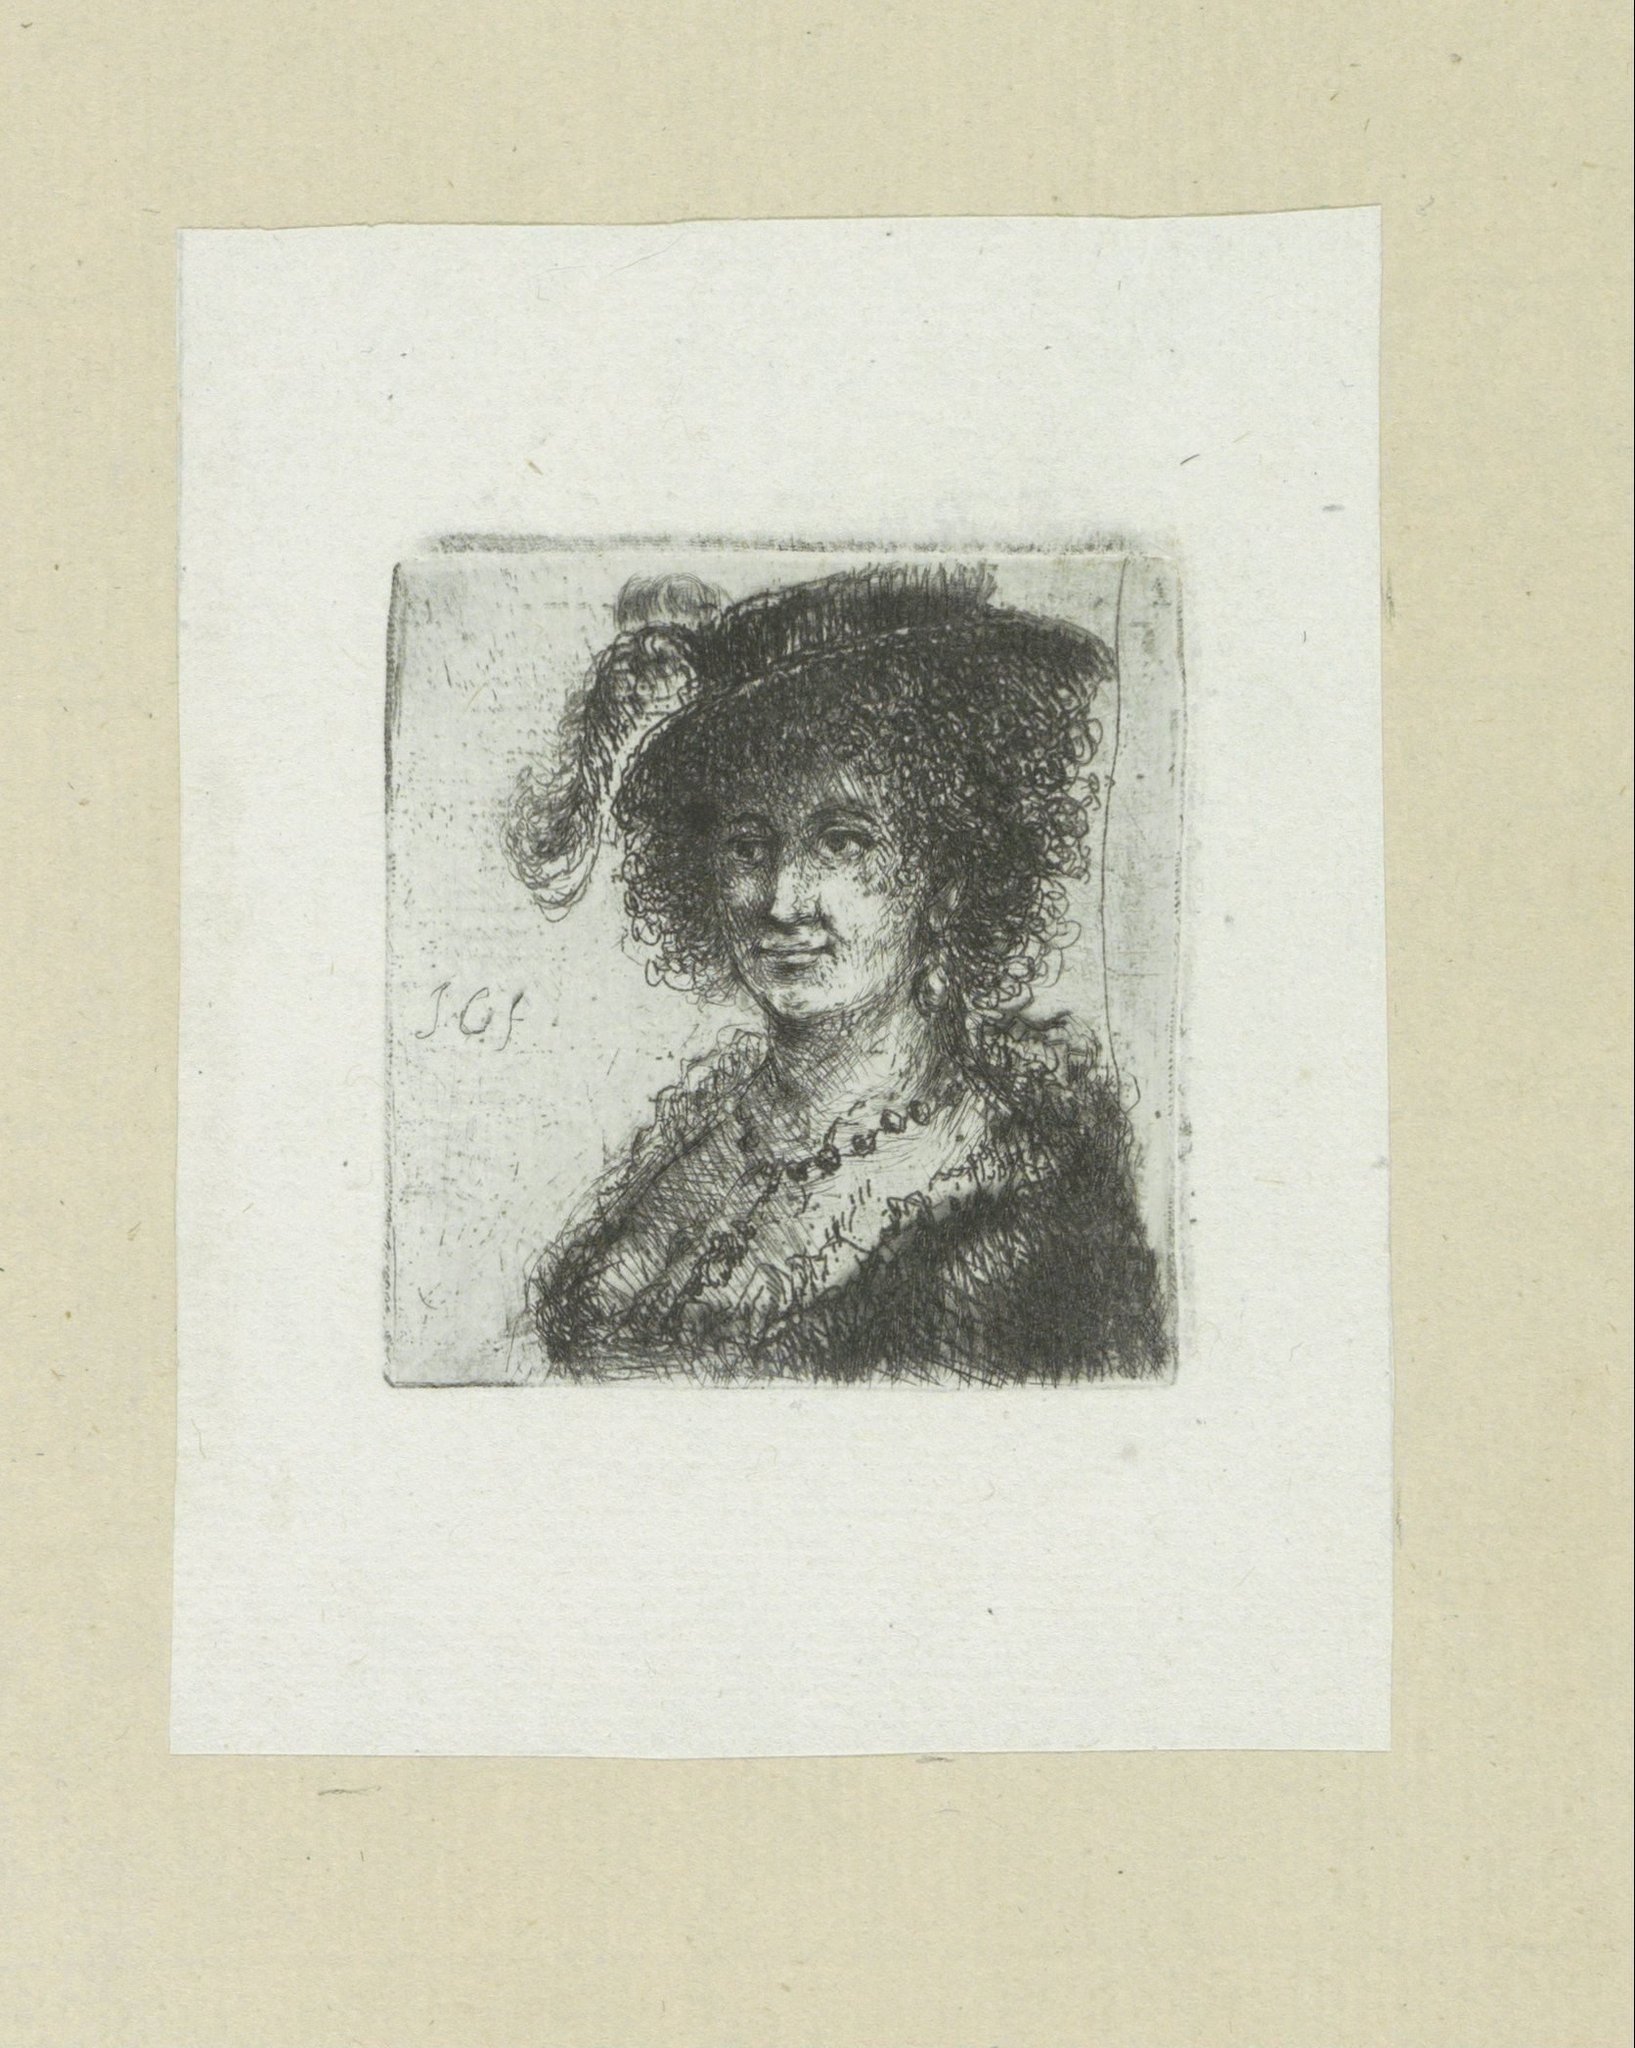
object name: print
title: Vrouw met hoed met veer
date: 1802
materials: paper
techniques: drypoint, etching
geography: amsterdam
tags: head-gear: hat (+ men's clothes), morphology of human expression (+ adult female (human being))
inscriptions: collector's mark: ‘RIJKS / MUSM’, collector's mark: ‘B’